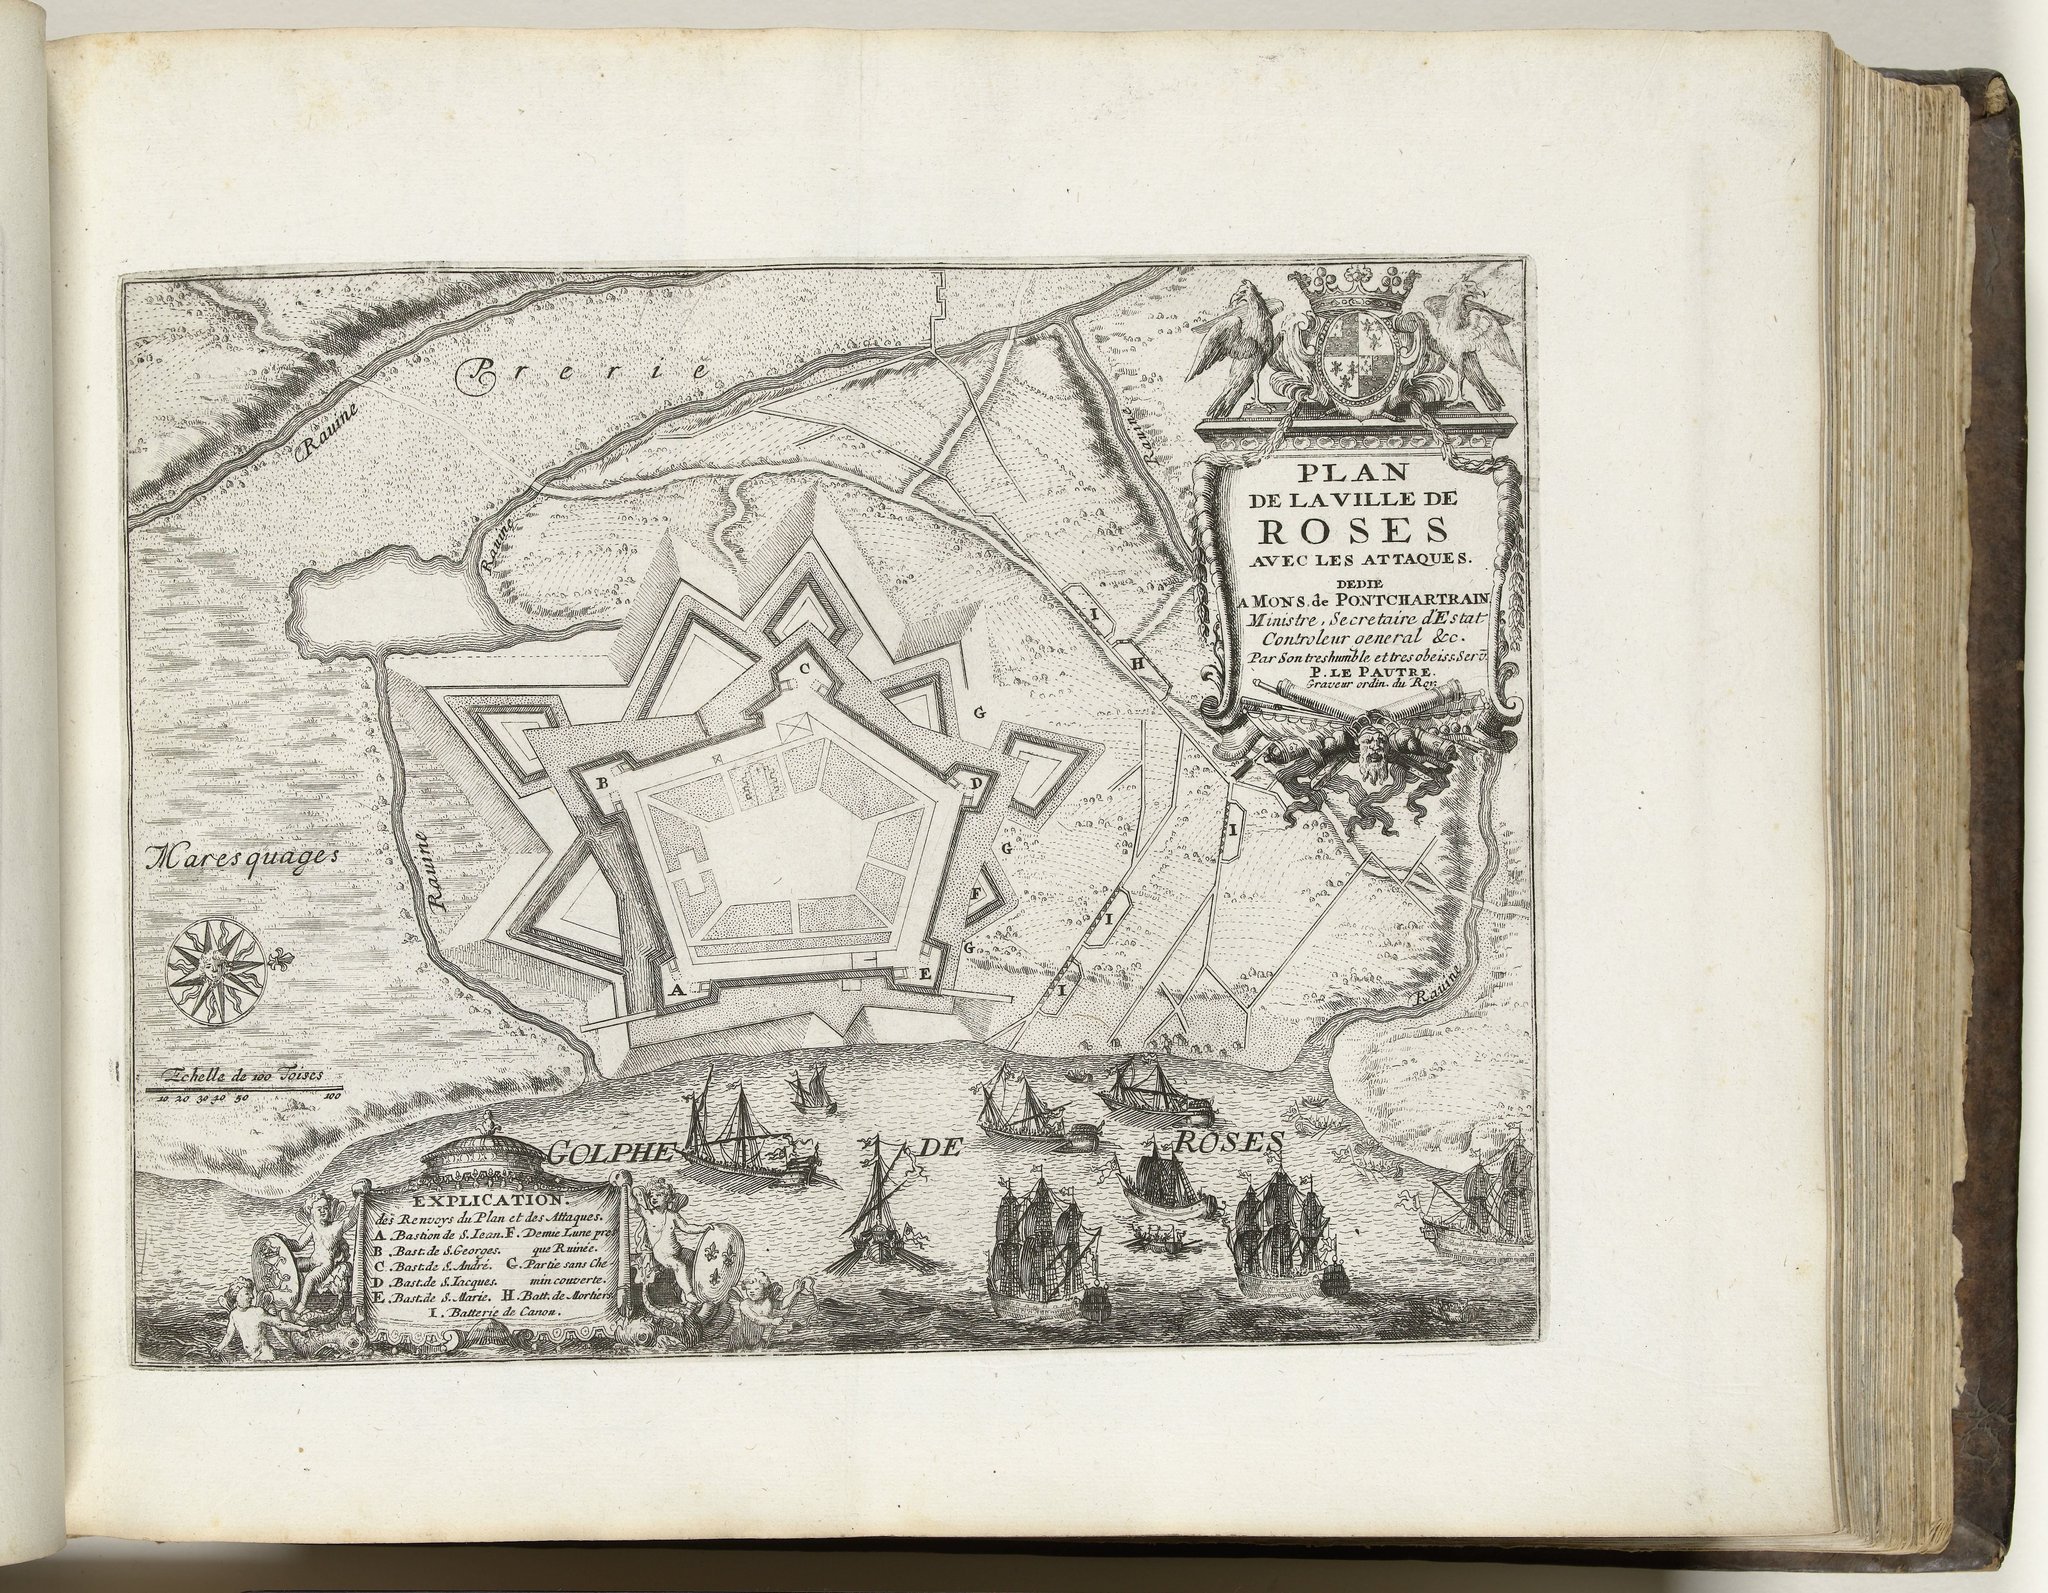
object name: print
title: Les forces de l'Europe, ou description des principales villes, avec leurs fortifications : dessignées par les meilleurs ingenieurs, particulierement celles (...) de la France, dont les plans ont esté levez par M. de Vauban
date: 1693-1695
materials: paper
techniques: etching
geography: france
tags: fortress, maps of cities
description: Plattegrond van de versterkingen om de Spaanse stad Rosas. Onderdeel van het derde deel (1695) van het prentwerk waarin gebundeld zijn de acht delen van Les forces de l'Europe uitgegeven tussen 1693-1697. Het prentwerk bestaat uit 175 platen met plannen (afkomstig van Sébastien Le Prestre, Seigneur de Vauban) van vermaarde sterke steden en vestingen in de Negenjarige Oorlog. Titel en opschriften in het Frans.